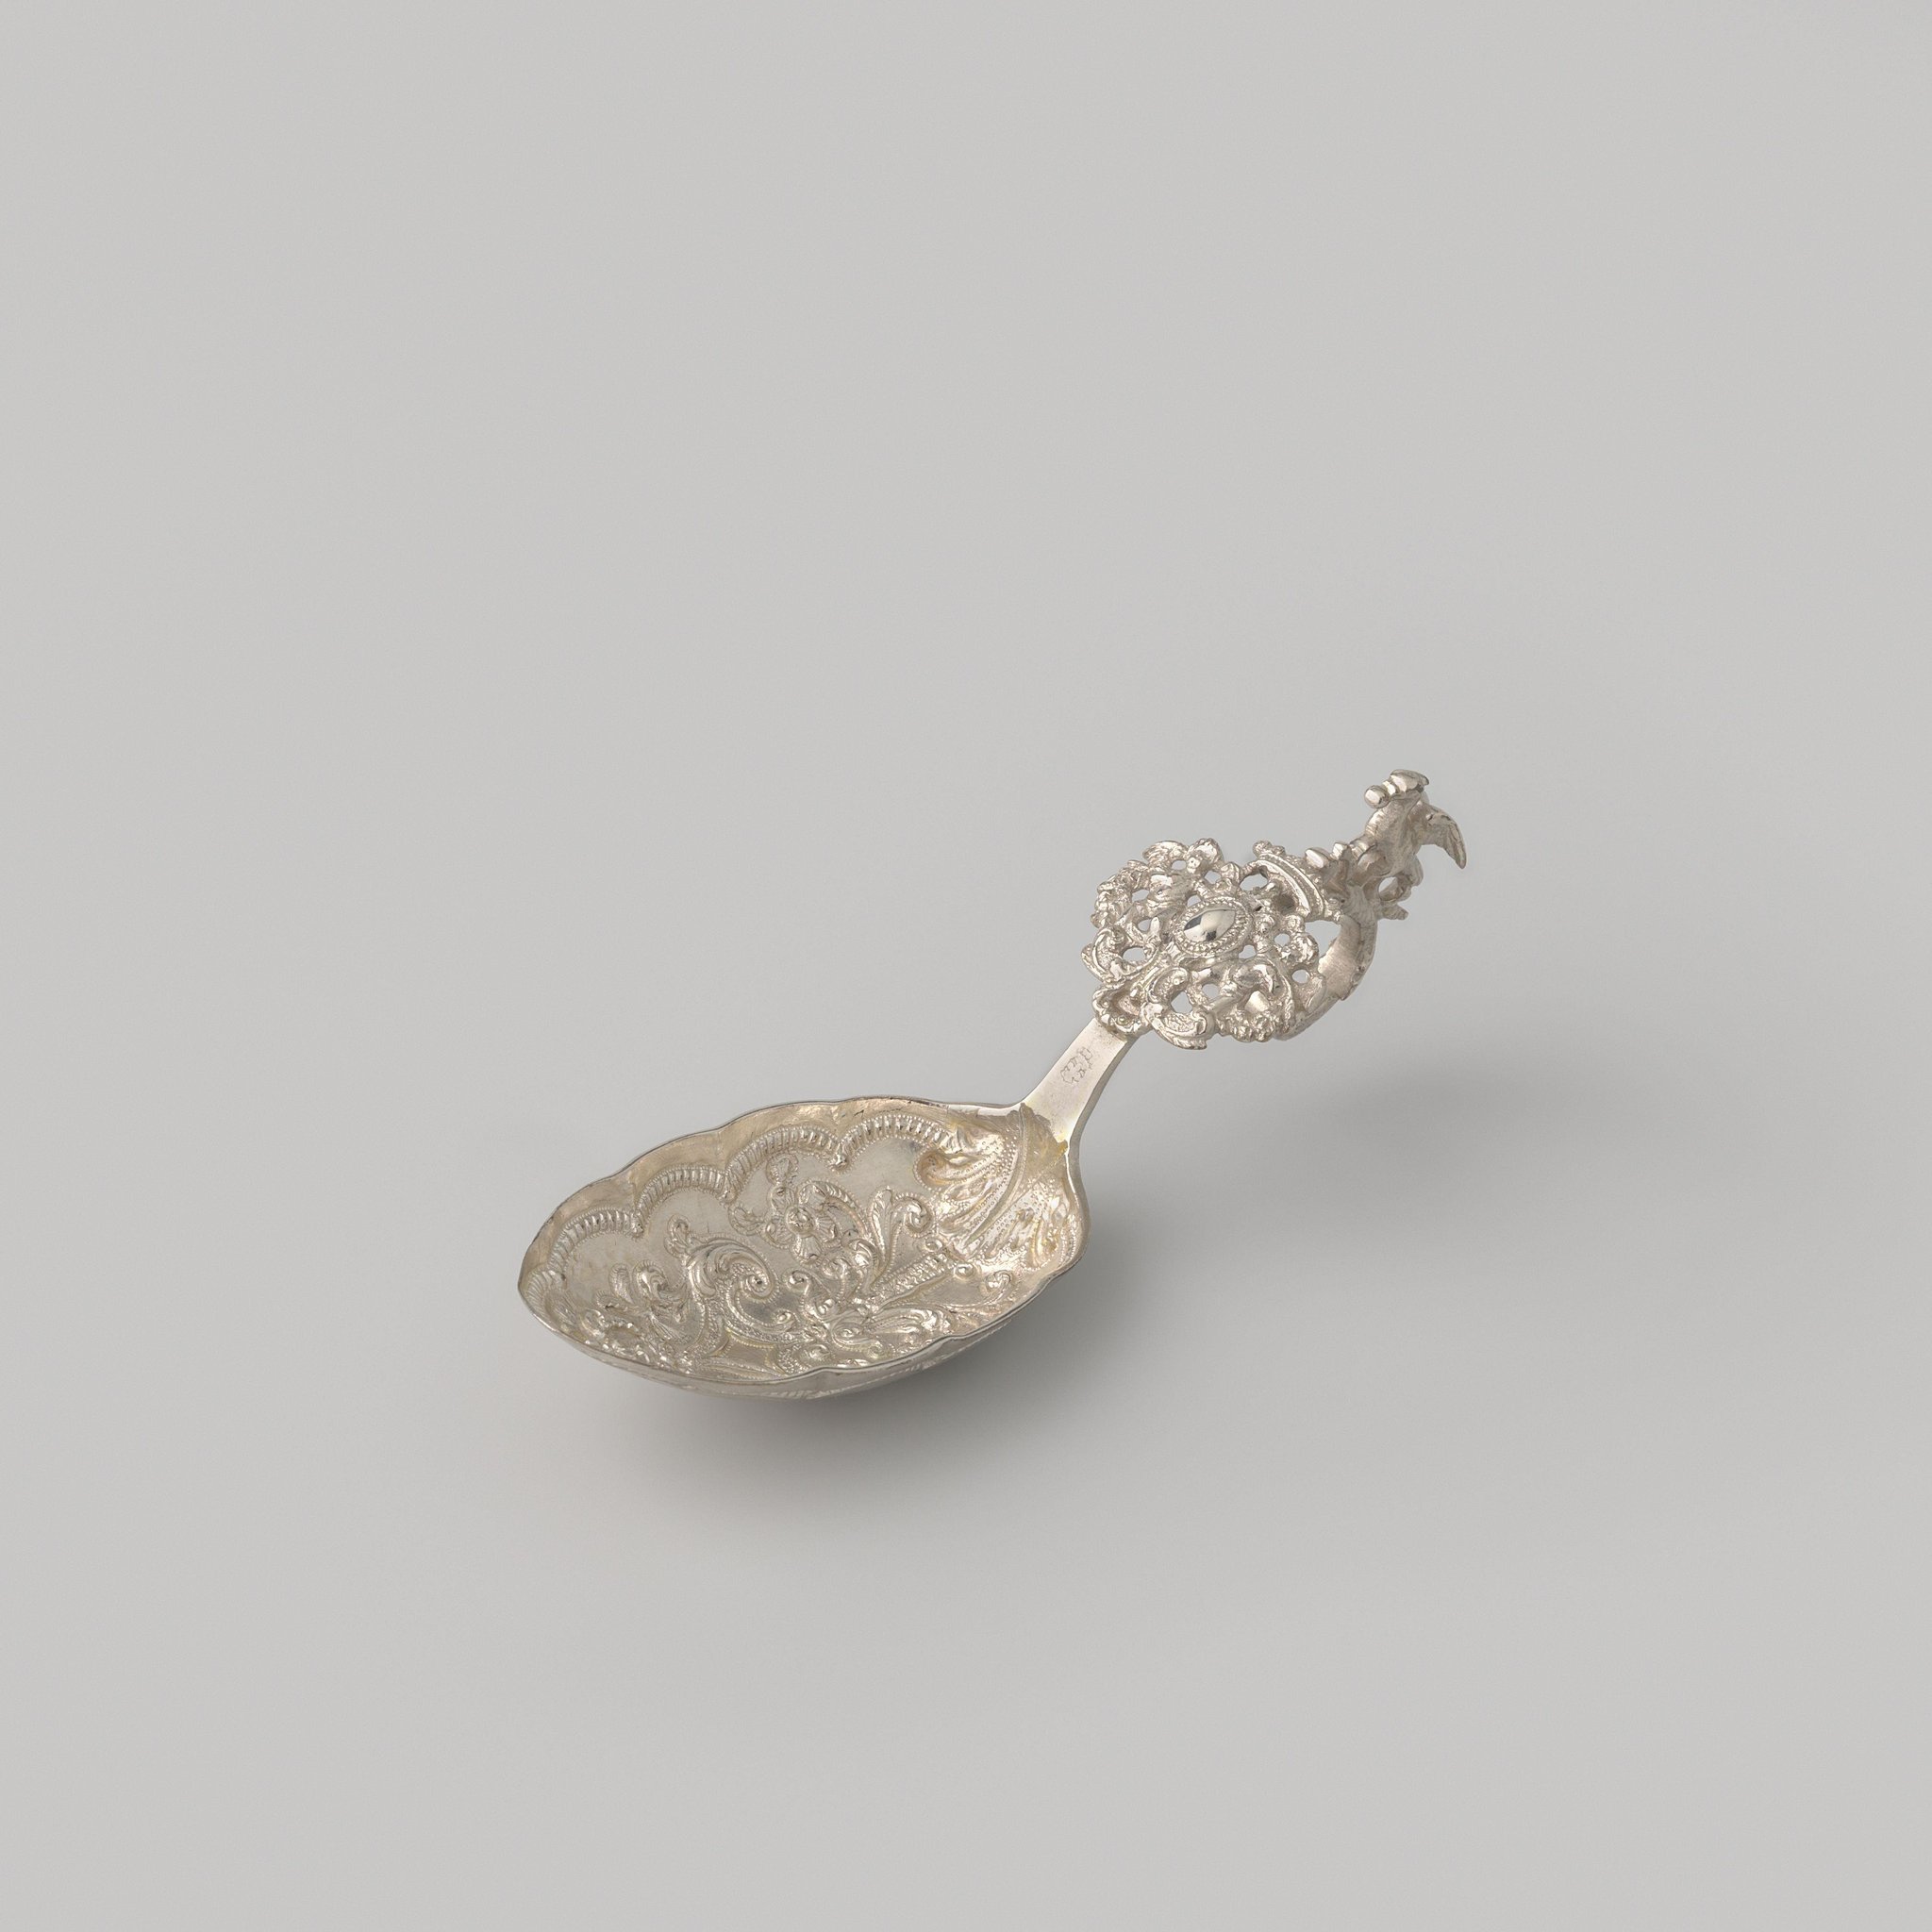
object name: cream ladle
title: Roomlepel met wapenschild met schoon veld, gekroond en gehouden door twee engelen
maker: johannes van der lely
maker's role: silversmith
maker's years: 1673-1749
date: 1725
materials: silver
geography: leeuwarden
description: Cream spoon. Zilver. Leeuwarden, c. 1725, by Johannes van der Lely.